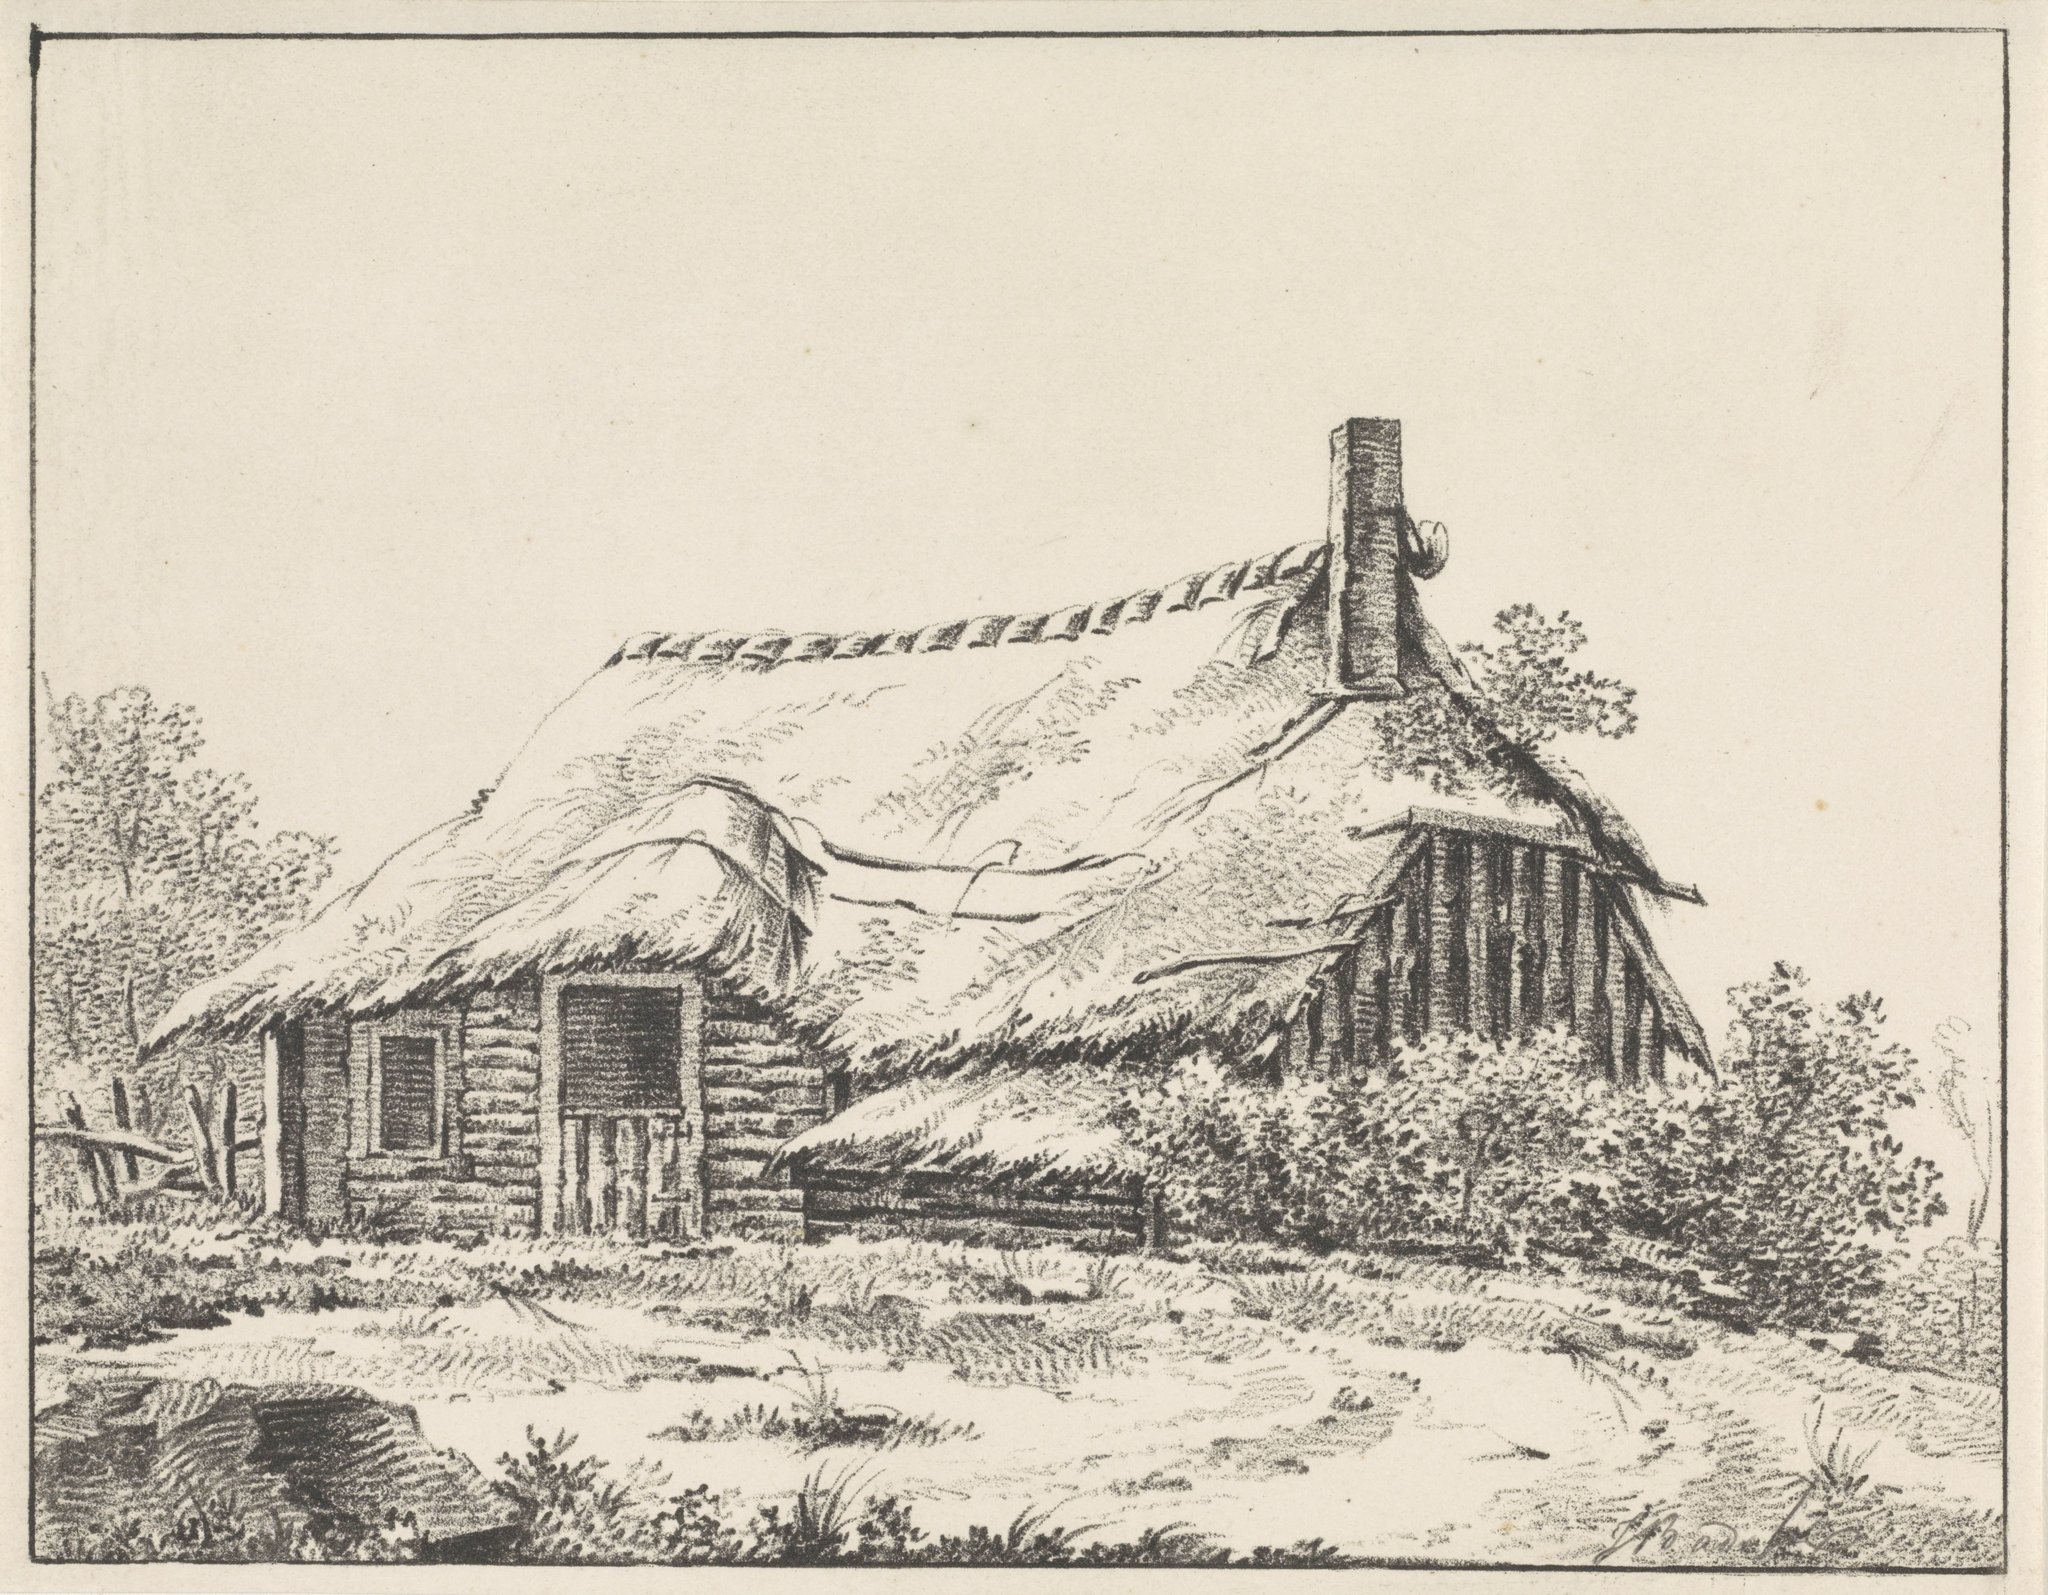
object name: print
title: Boerenhoeve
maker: joannes bemme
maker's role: print maker, printer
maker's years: 1775-1841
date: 1809-1841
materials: paper, pencil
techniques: lithograph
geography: netherlands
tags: farm or solitary house in landscape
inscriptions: signature:, collector's mark: Lugt 2228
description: Zichtbaar zijn de deur en een raam. De hoeve heeft een schoorsteen en een rieten dak.